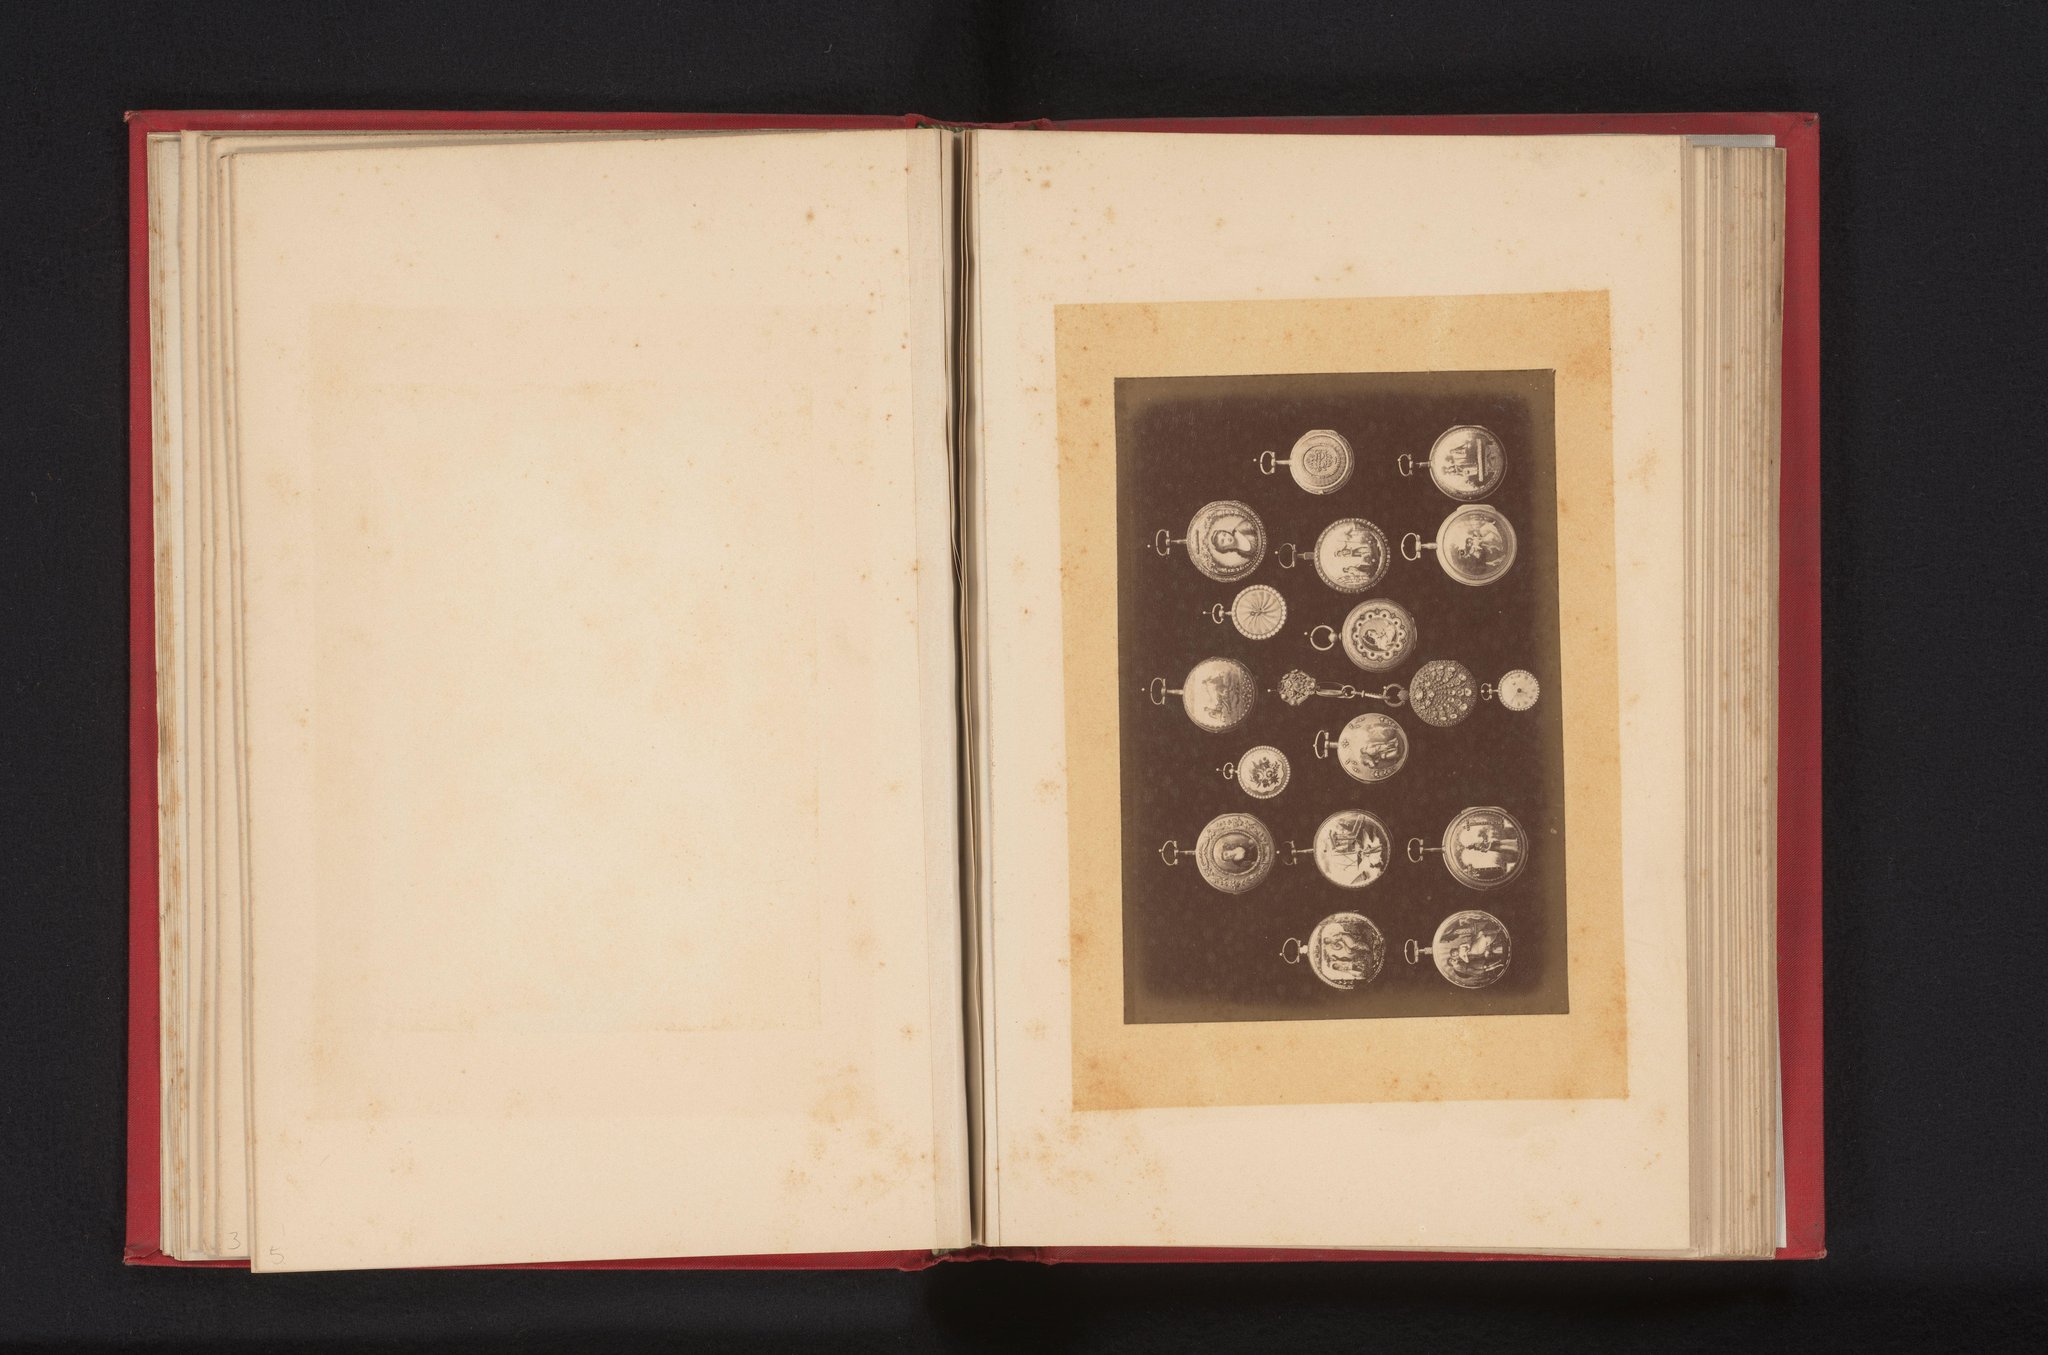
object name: photograph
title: Verschillende zakhorloges met illustraties op de kast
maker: Anonymous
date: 1872-1878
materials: photographic support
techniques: albumen print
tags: watch